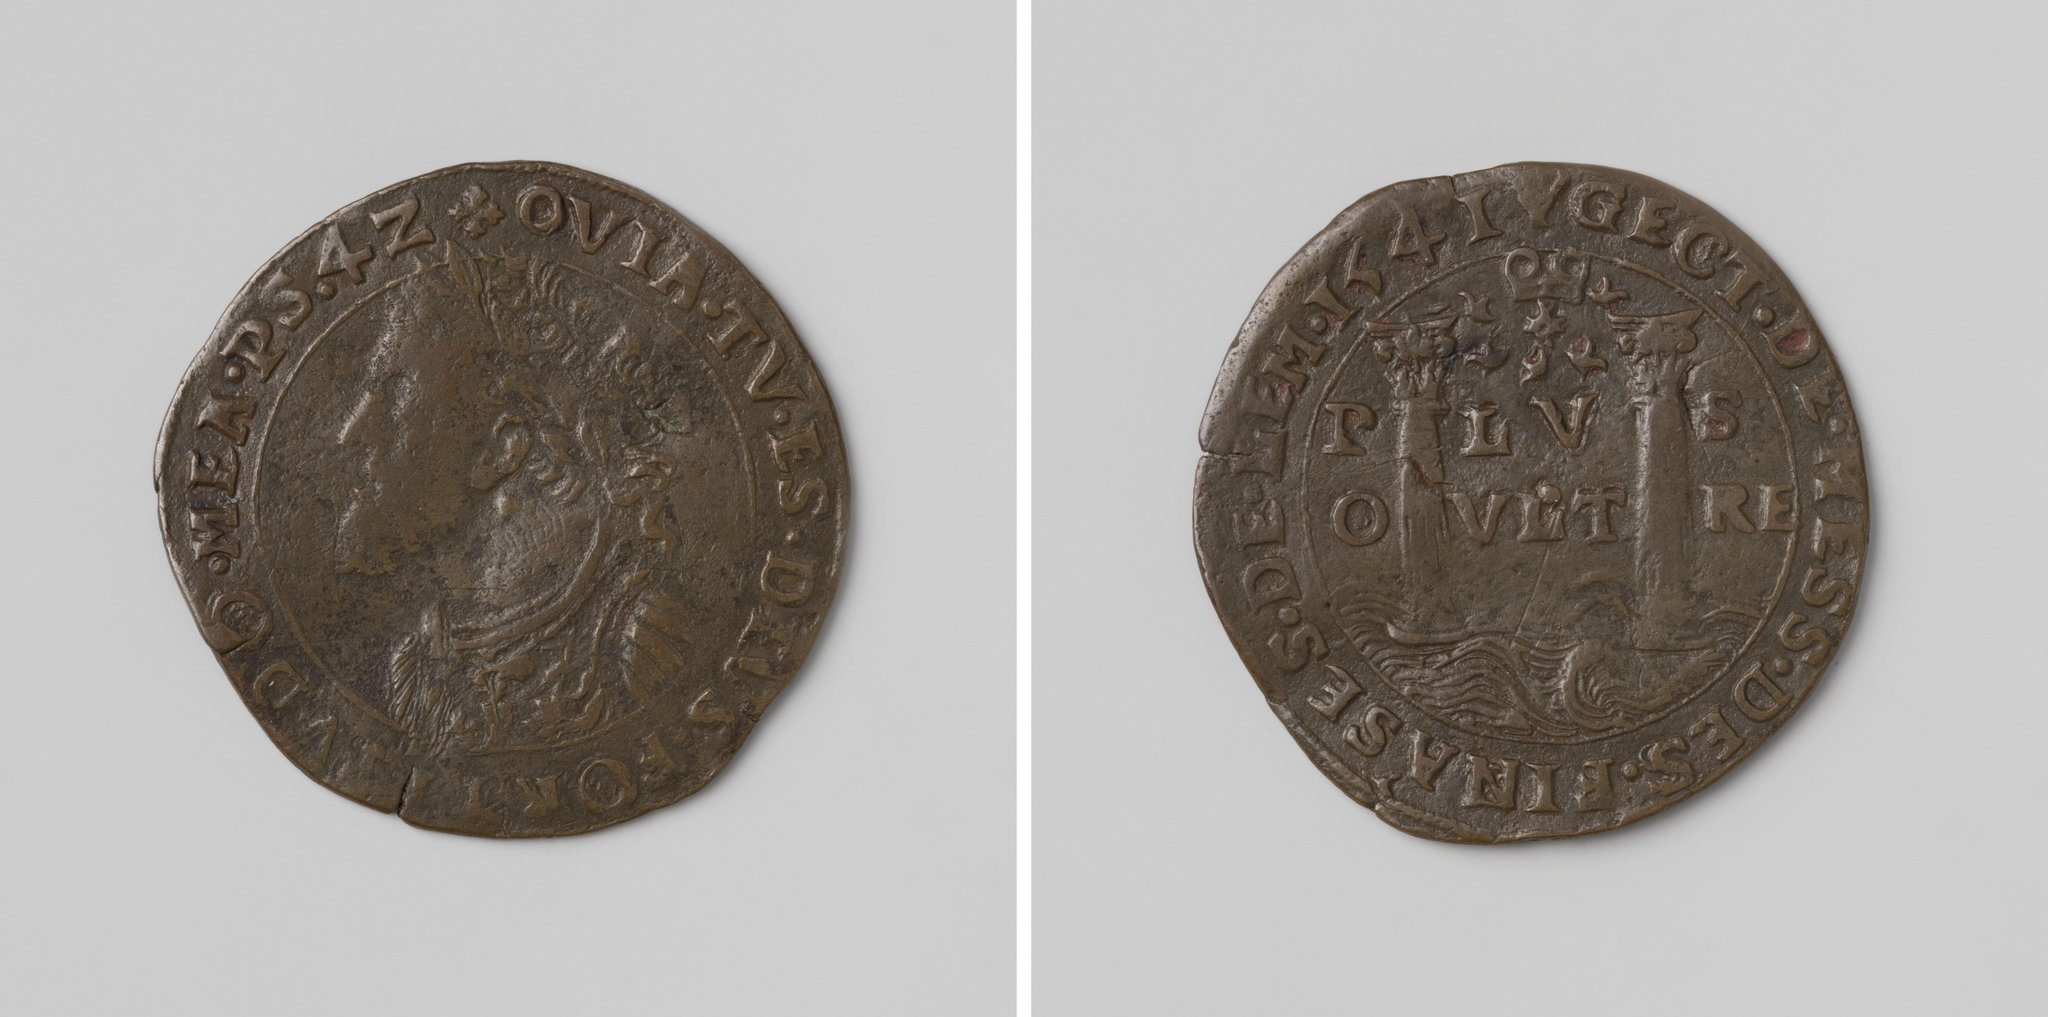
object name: jeton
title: Karel V, Duits keizer, rekenpenning van de raad van Financiën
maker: Anonymous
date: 1541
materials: copper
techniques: striking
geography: antwerp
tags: ghent, charles v (holy roman emperor and king of spain)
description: Koperen penning. Voorzijde: borststuk man met lauwerkrans binnen omschrift. Keerzijde: opschrift onder vuurslag, waar vonken uit schieten tussen zuilen van Herkules binnen omschrift